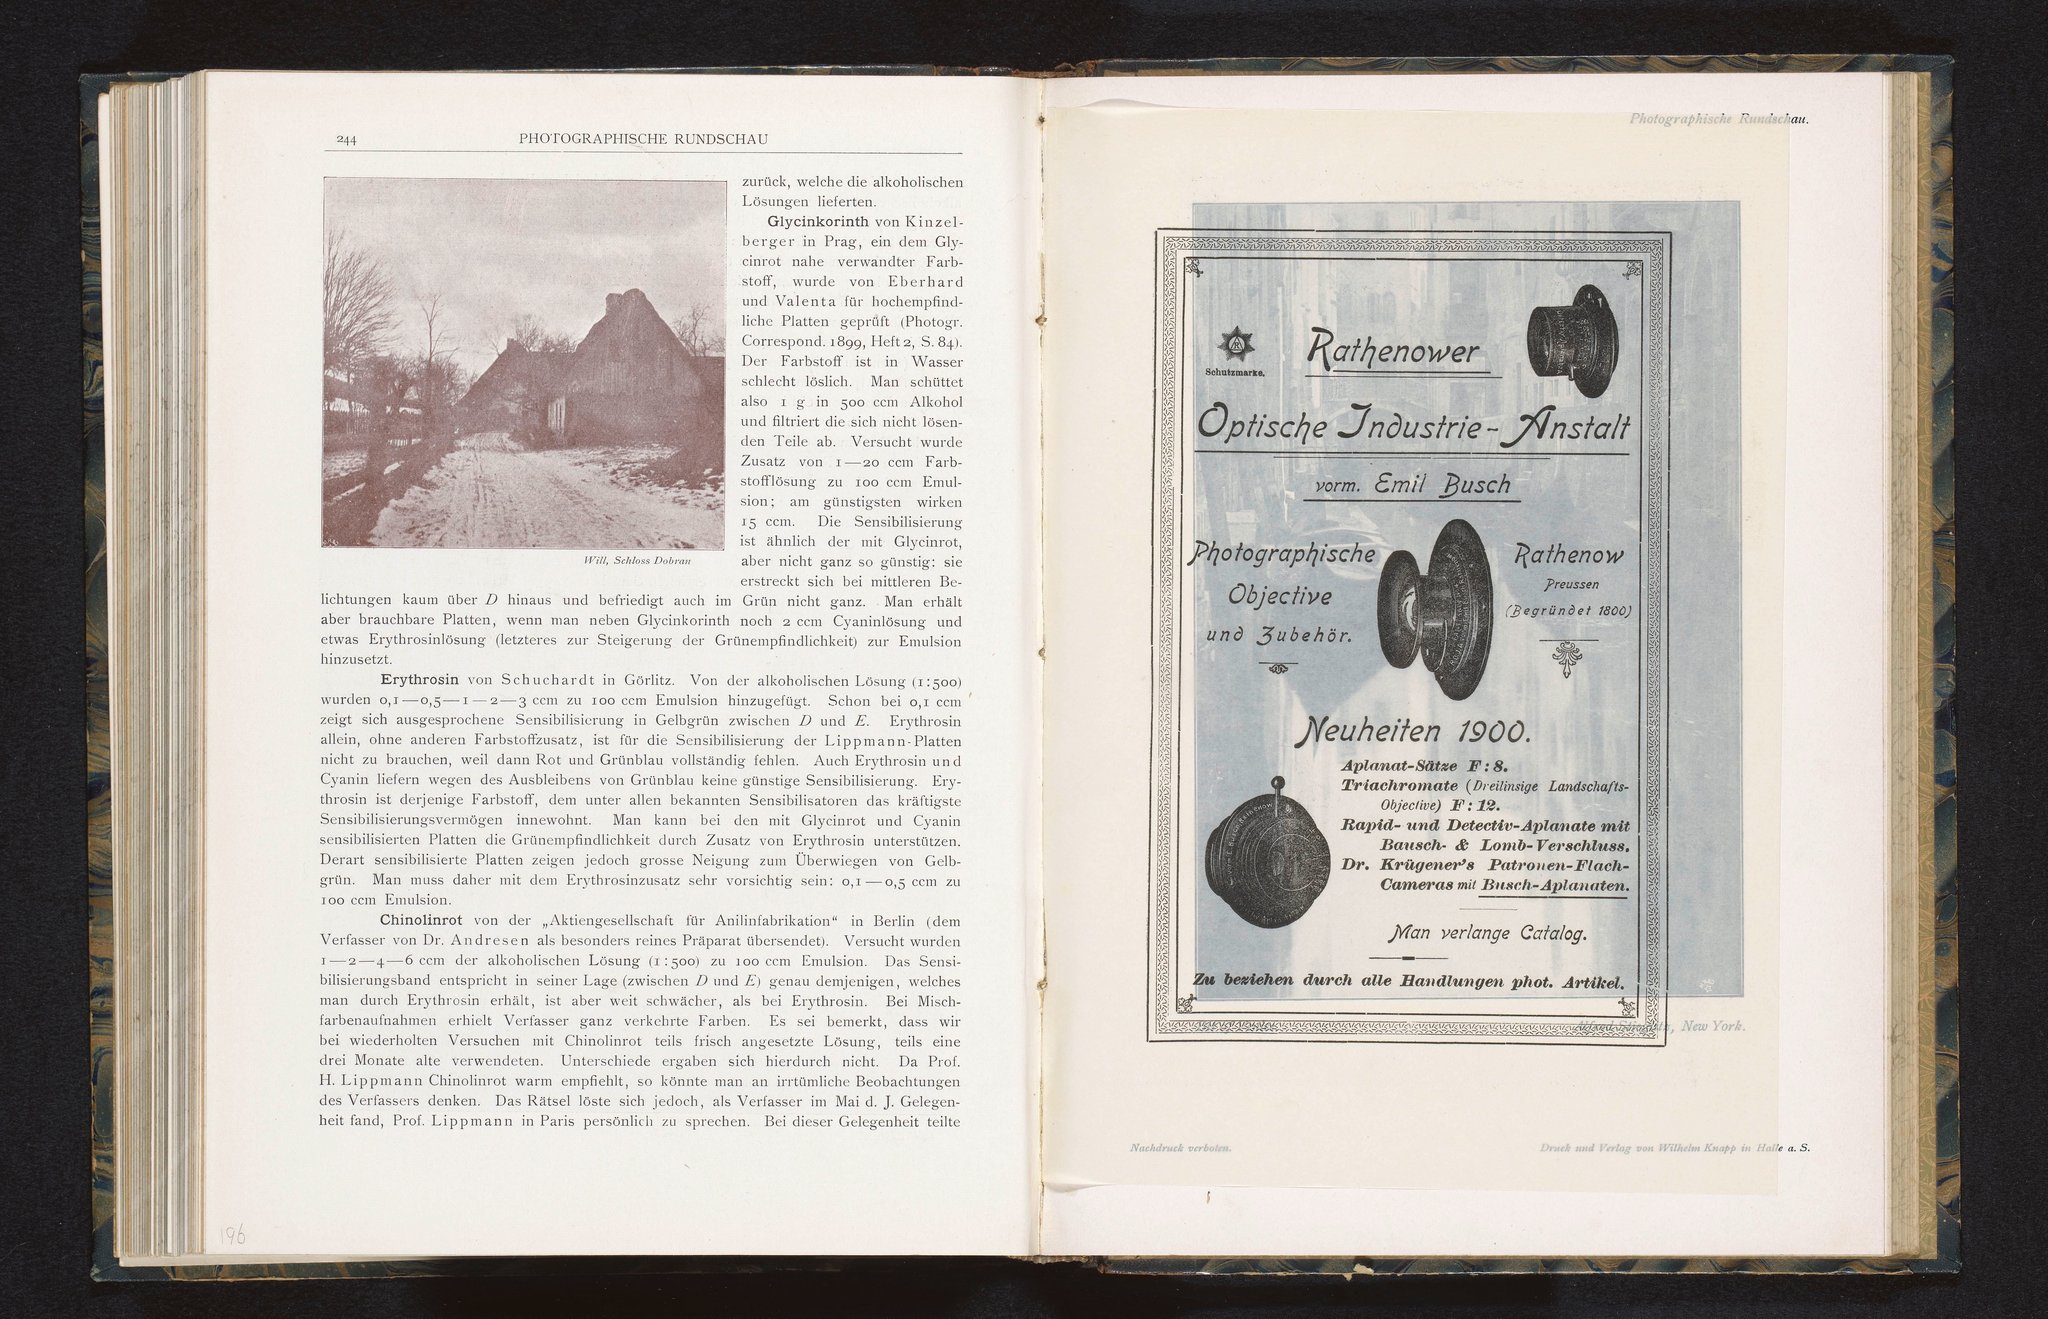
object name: page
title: Gezicht op een weg met twee huizen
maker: will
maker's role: fotograaf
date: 1895-1900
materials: paper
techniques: autotype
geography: berlin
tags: rural housing, e.g. country-house, villa, cottage, road, path, snow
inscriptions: monogram: ‘MR&C’